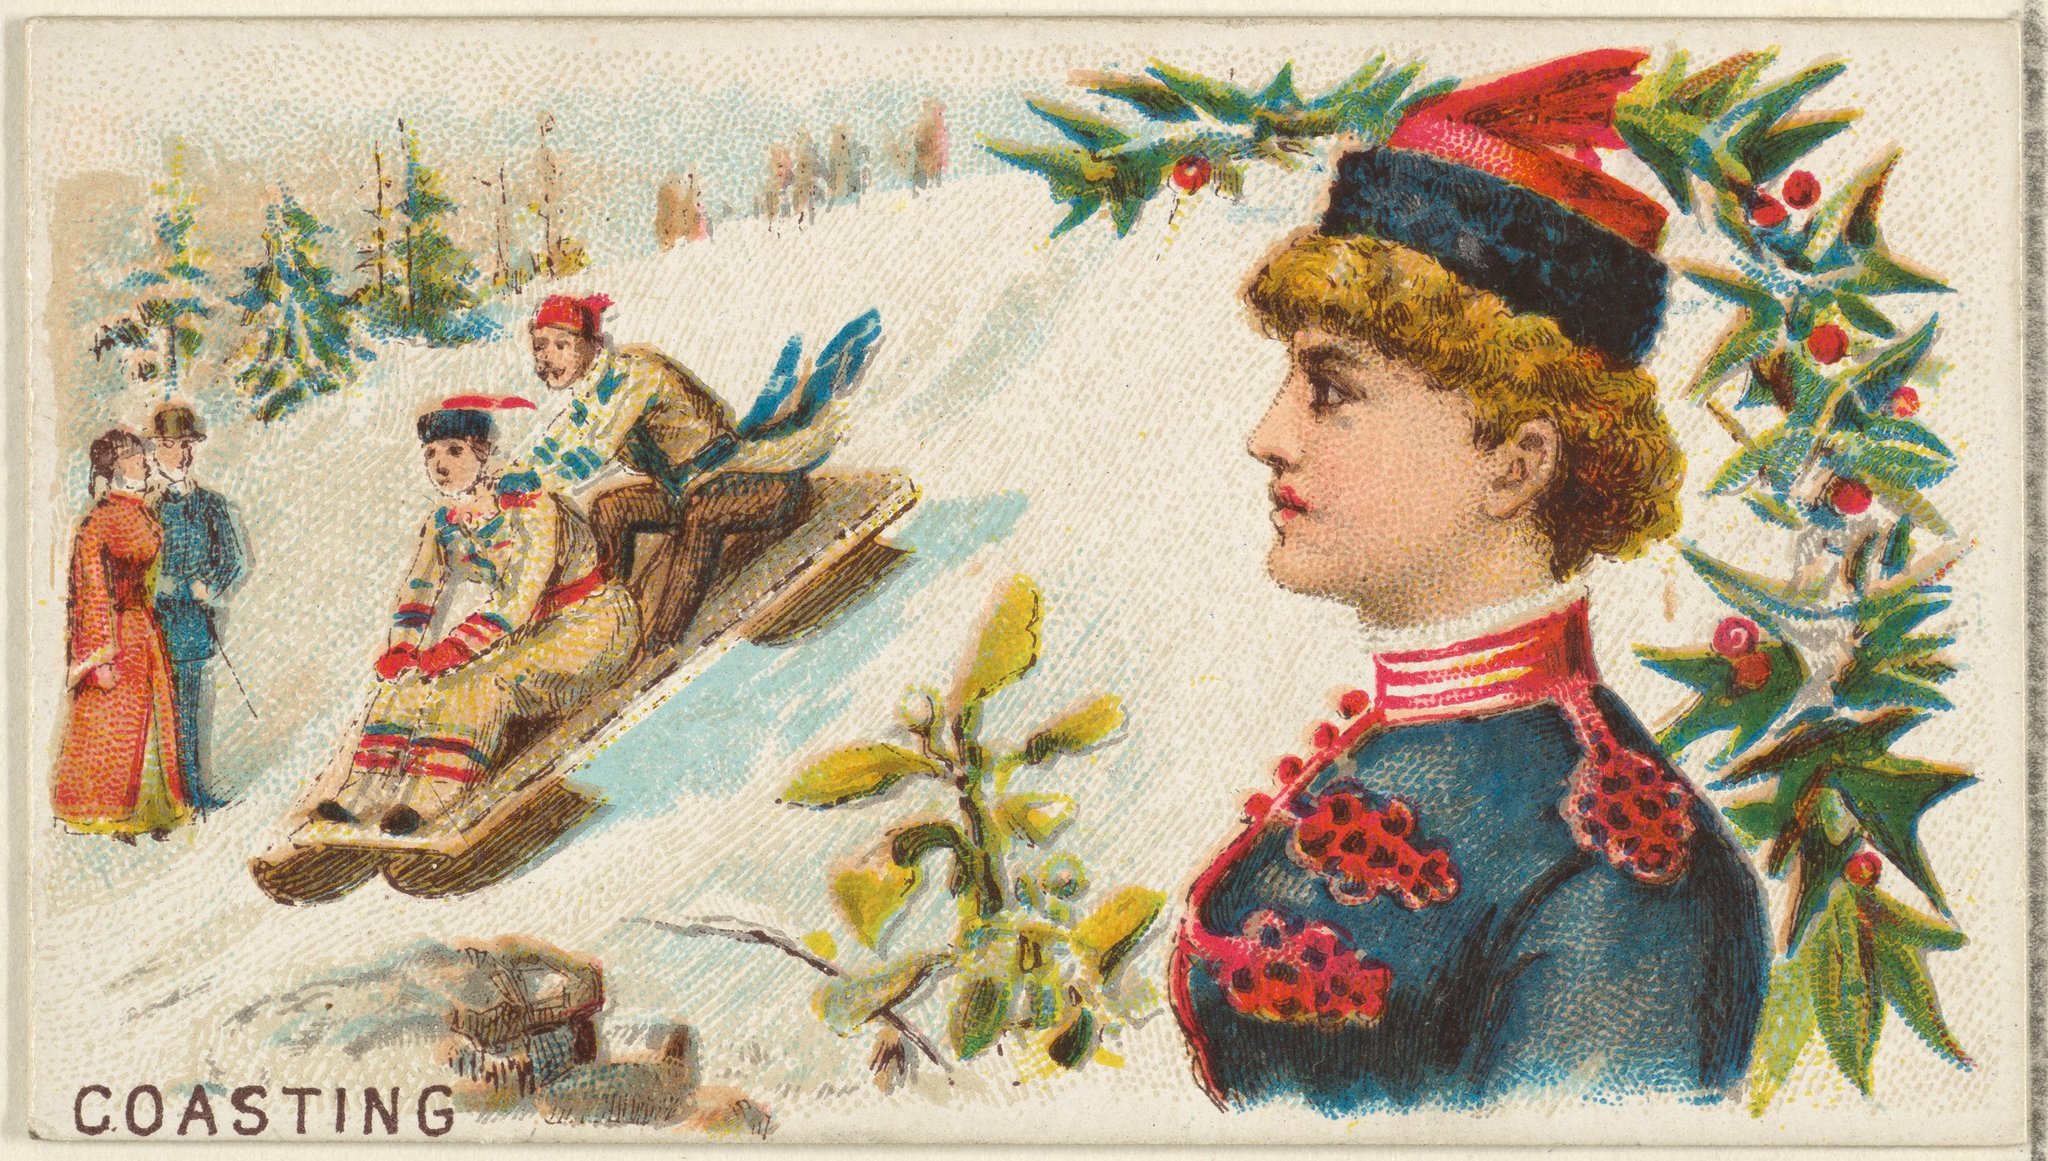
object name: print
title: Coasting, from the Games and Sports series (N165) for Old Judge Cigarettes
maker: goodwin & company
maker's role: publisher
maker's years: 1850-1950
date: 1889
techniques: color lithograph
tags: women,sledging